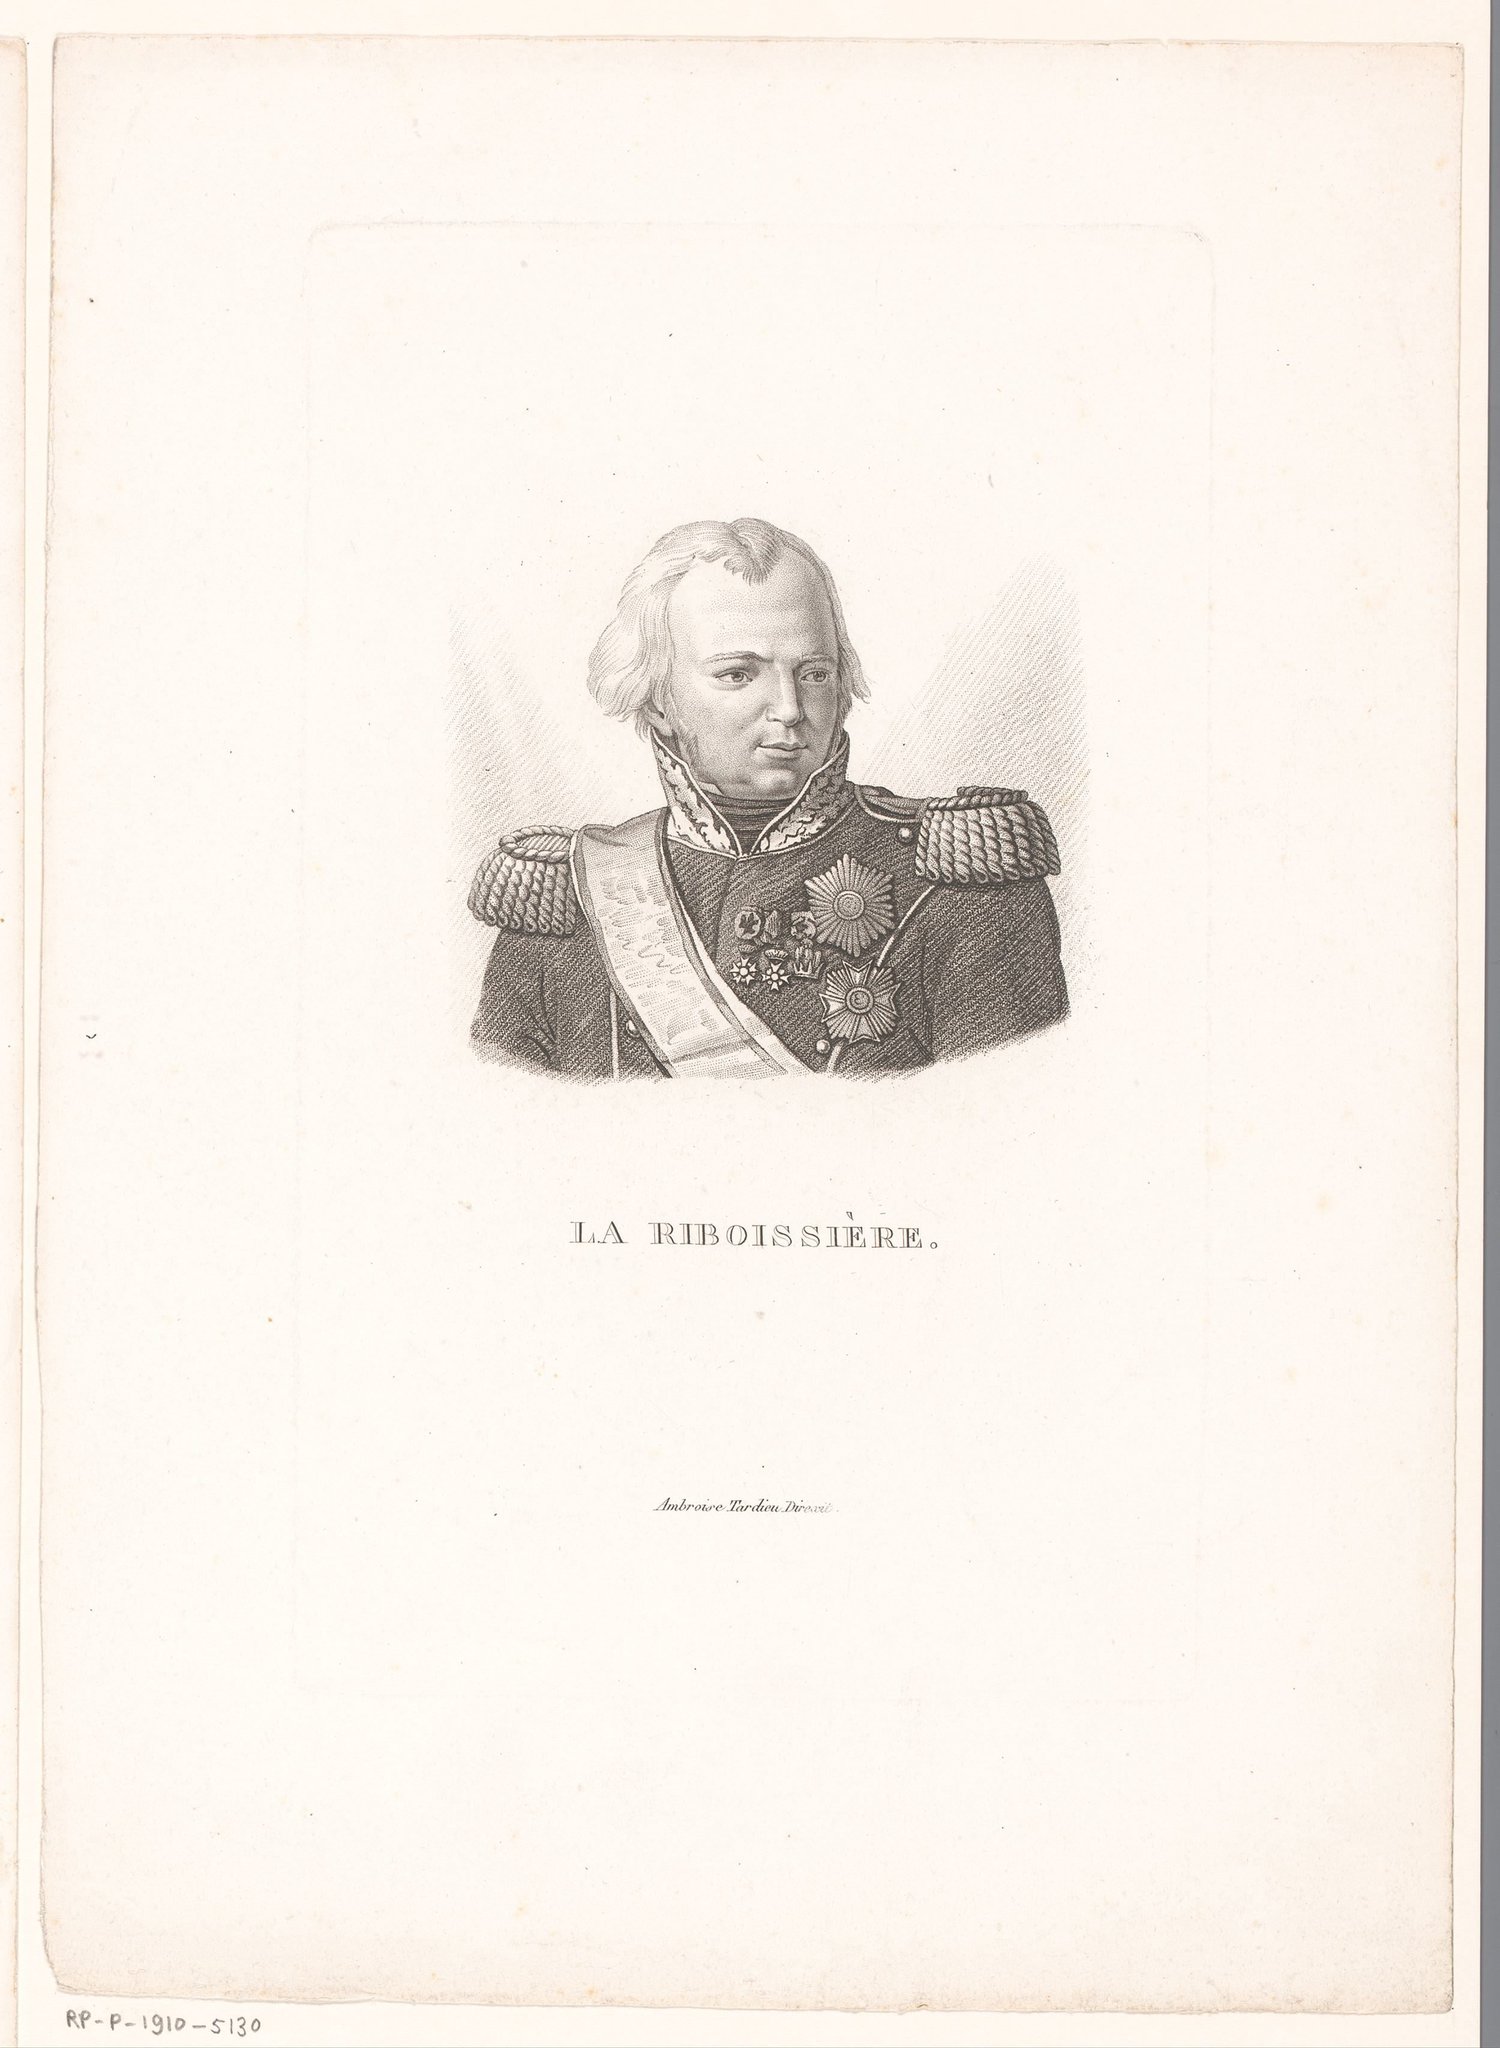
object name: book illustration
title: Portret van Jean Ambroise Baston de Lariboisière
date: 1818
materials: paper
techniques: engraving, roulette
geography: paris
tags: commander-in-chief, general, marshal, historical persons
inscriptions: collector's mark: Lugt 2228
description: Mogelijk prent uit: Tardieu, Ambroise. Portraits des généraux français, faisant suite aux "Victoires et conquêtes des Français". Parijs: Panckoucke, Charles Louis Fleury, ca. 1818.